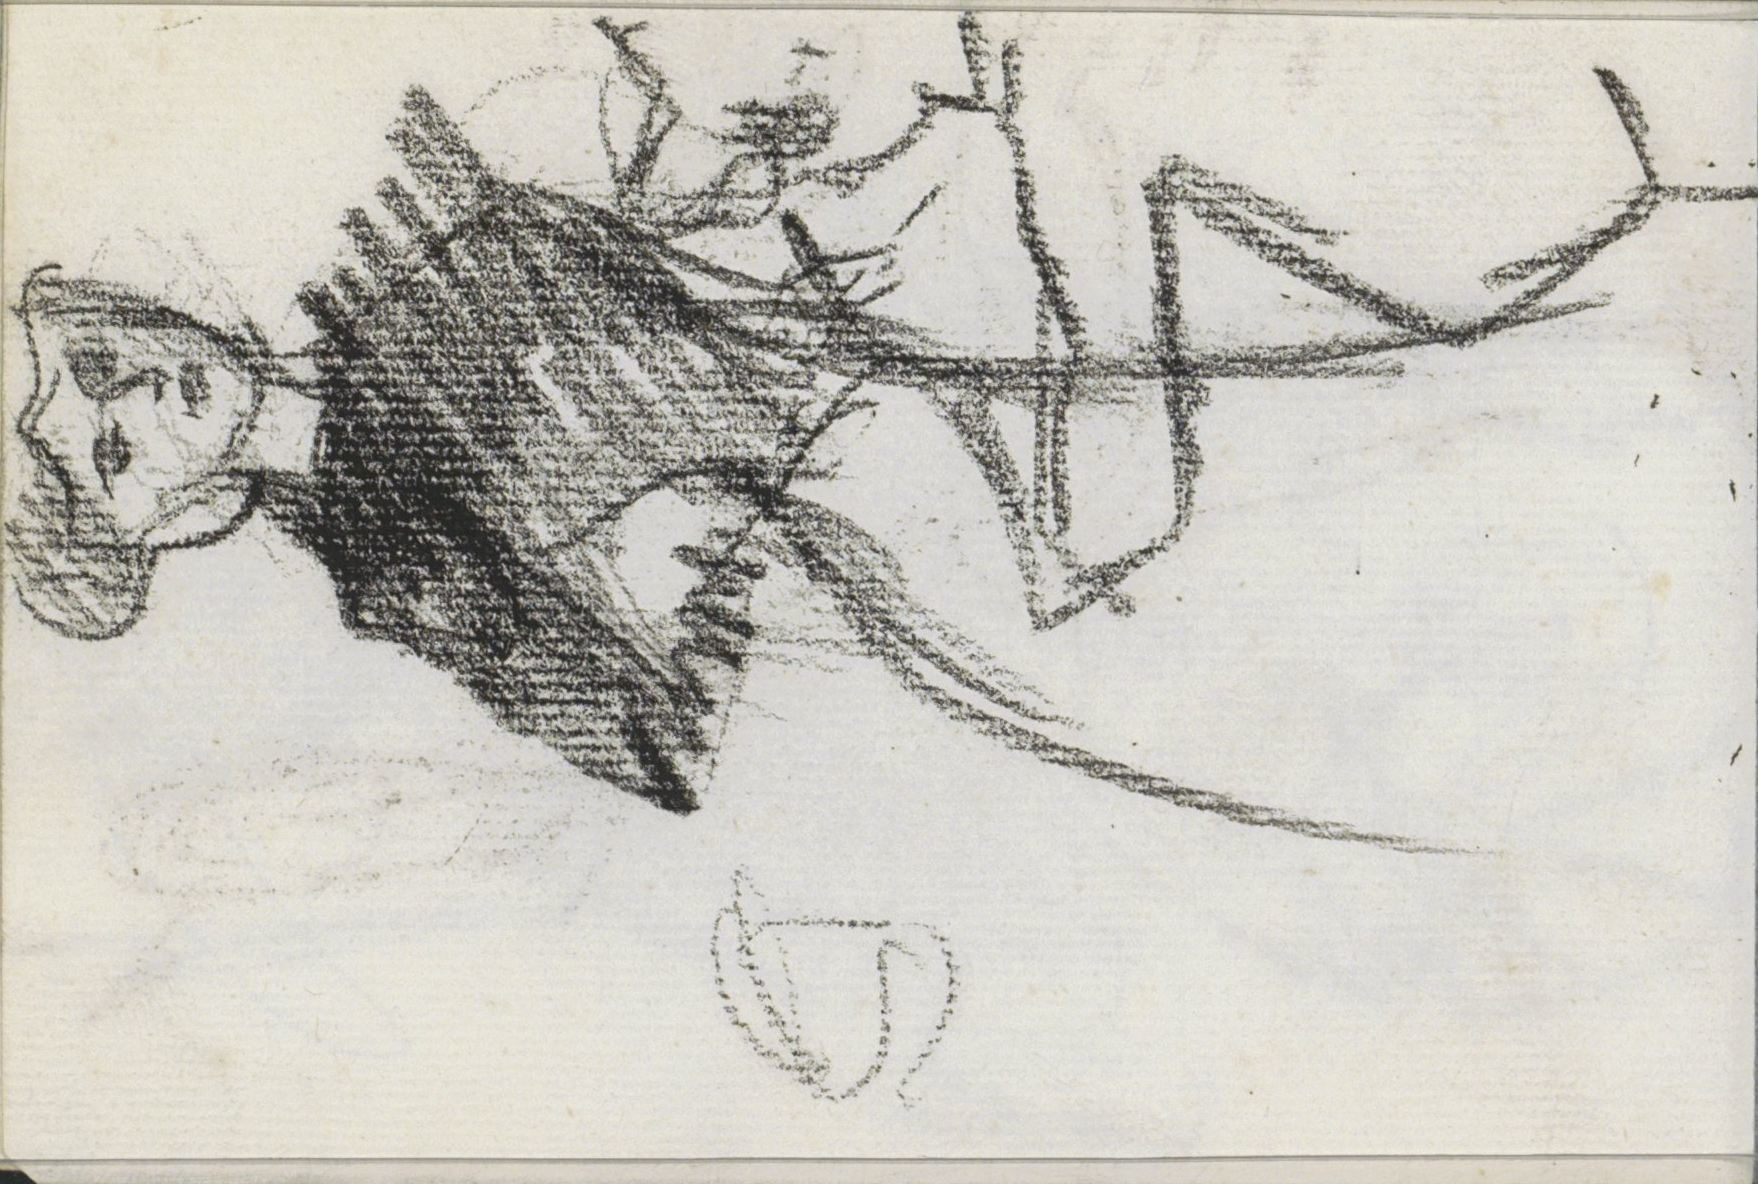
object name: sketchbook leaf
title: Kind voor een staande vrouw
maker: isaac israels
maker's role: draughtsman, painter, print maker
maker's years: 1865-1934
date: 1875-1934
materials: chalk, paper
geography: the hague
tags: child, adult woman (+ standing)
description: Blad 22 verso uit schetsboek XXX met 32 bladen.